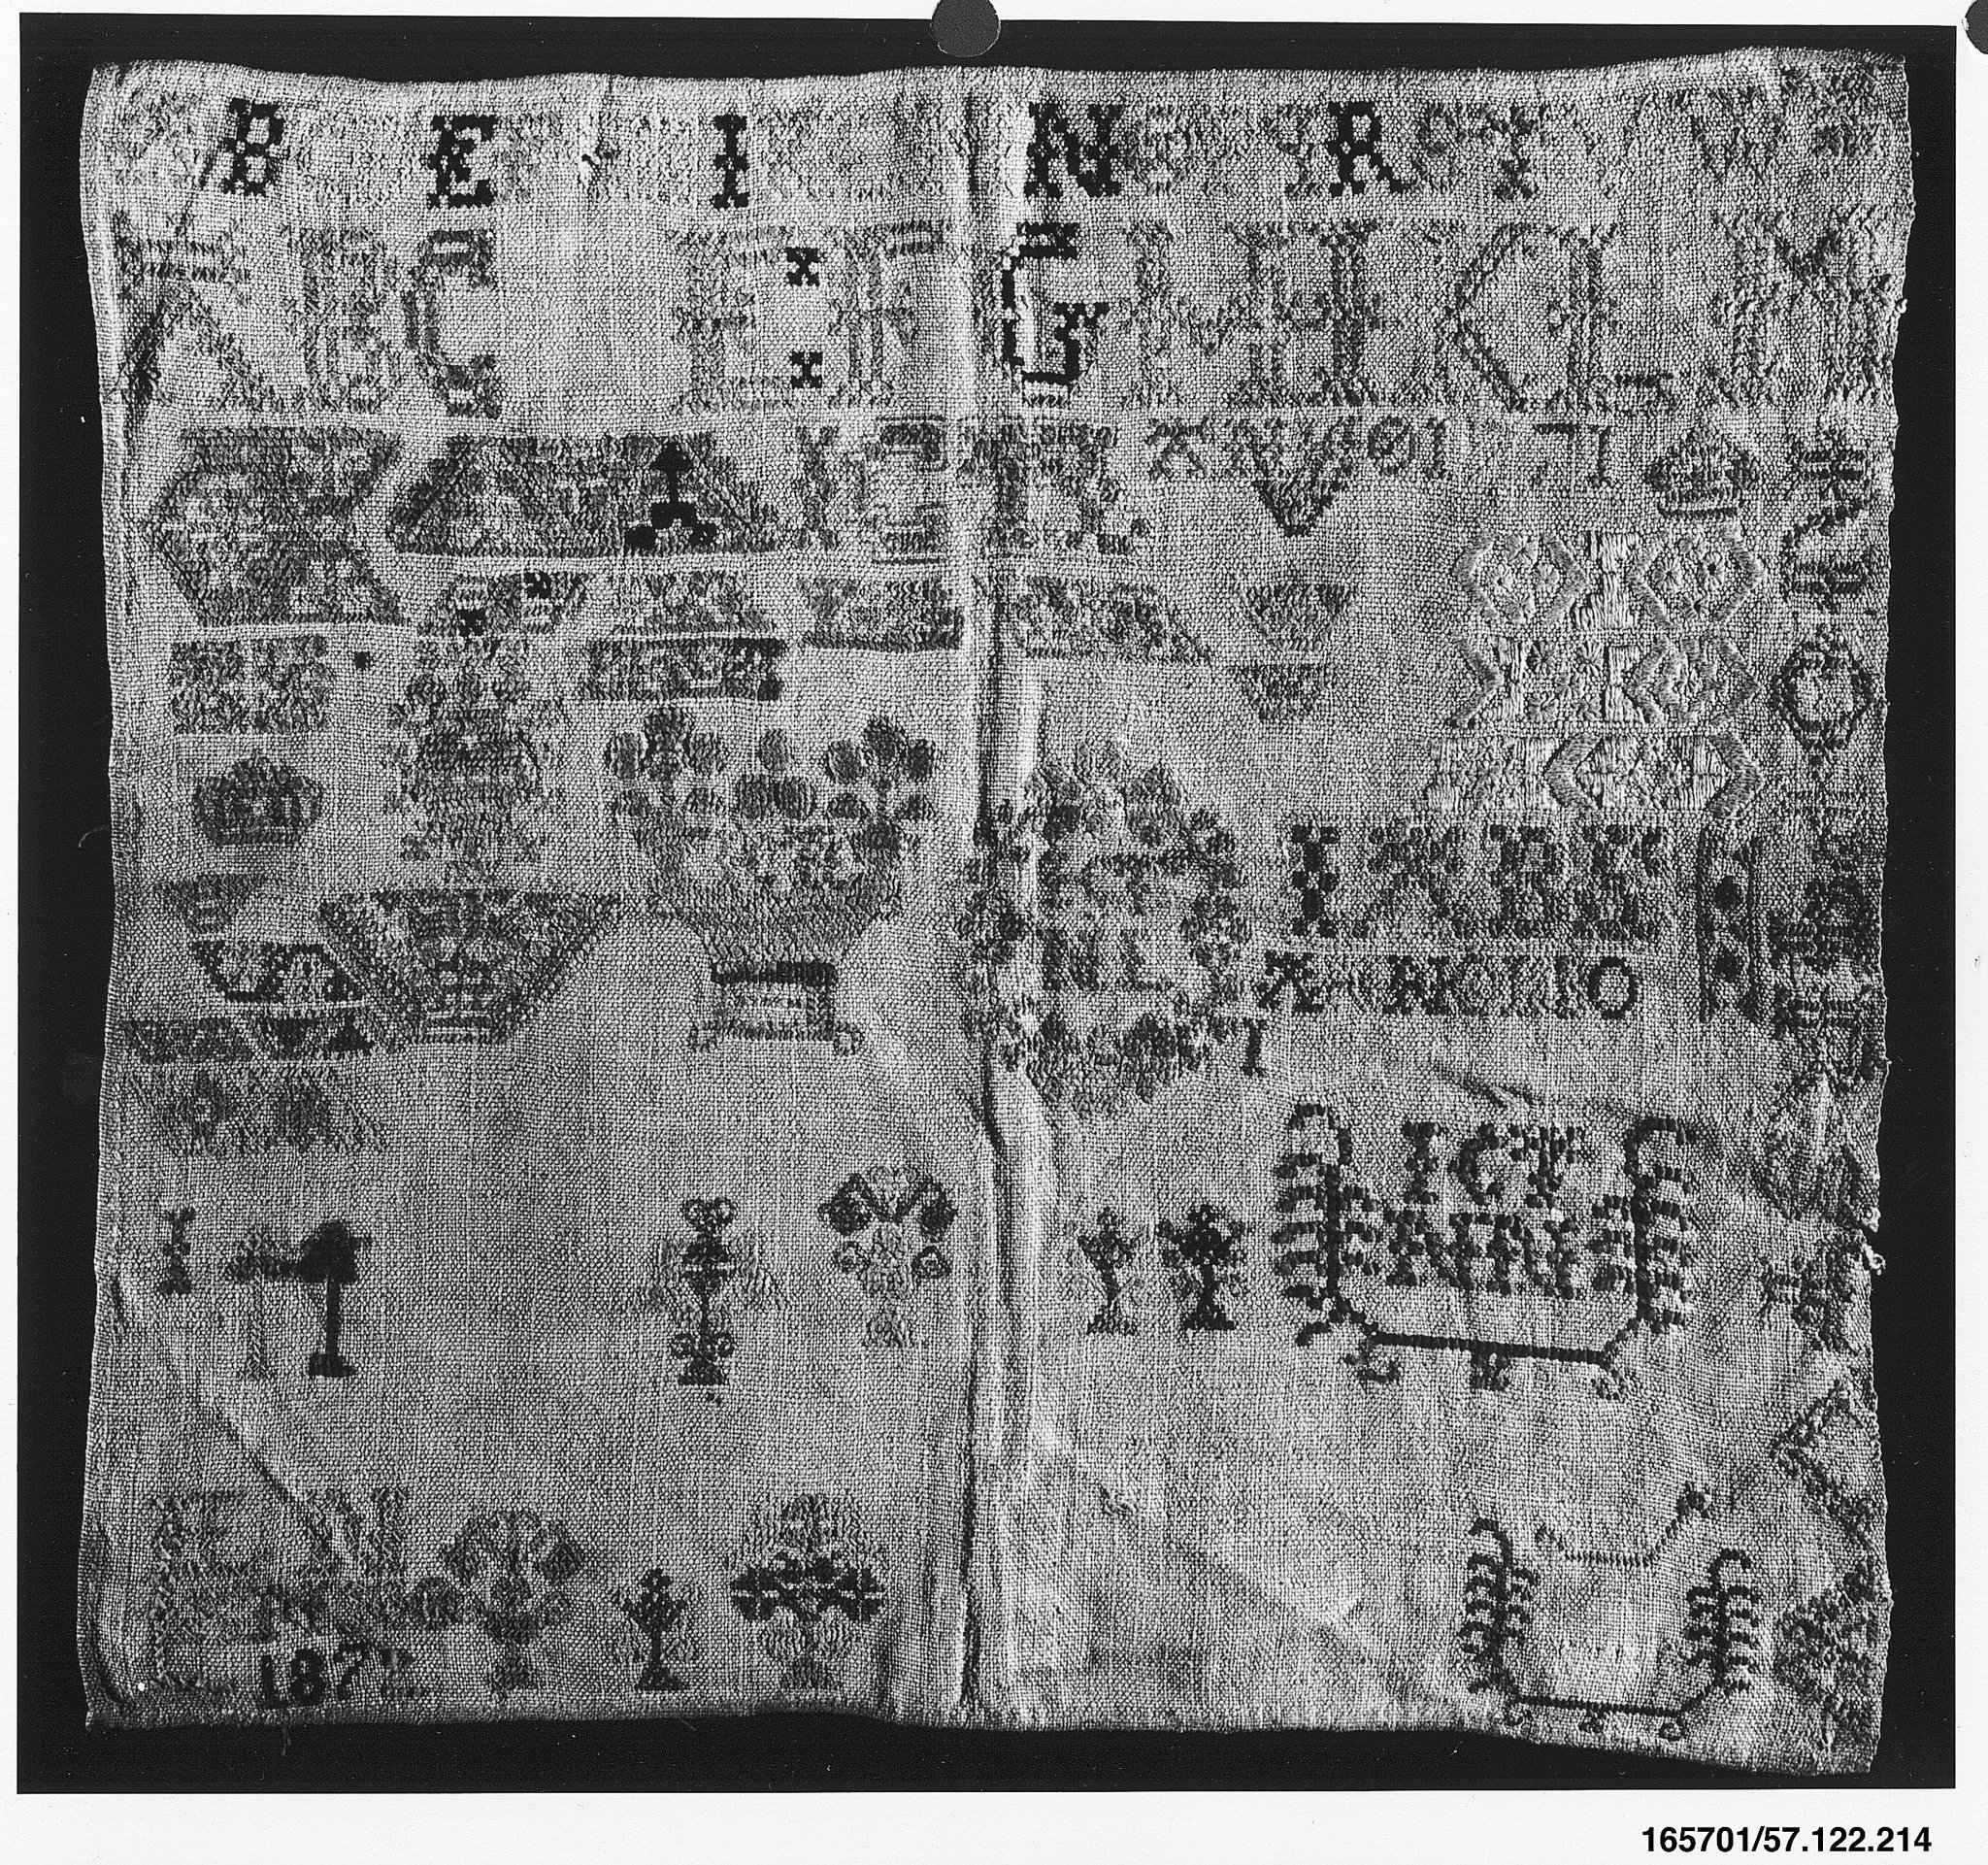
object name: sampler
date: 1701-1900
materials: cotton, linen, wool